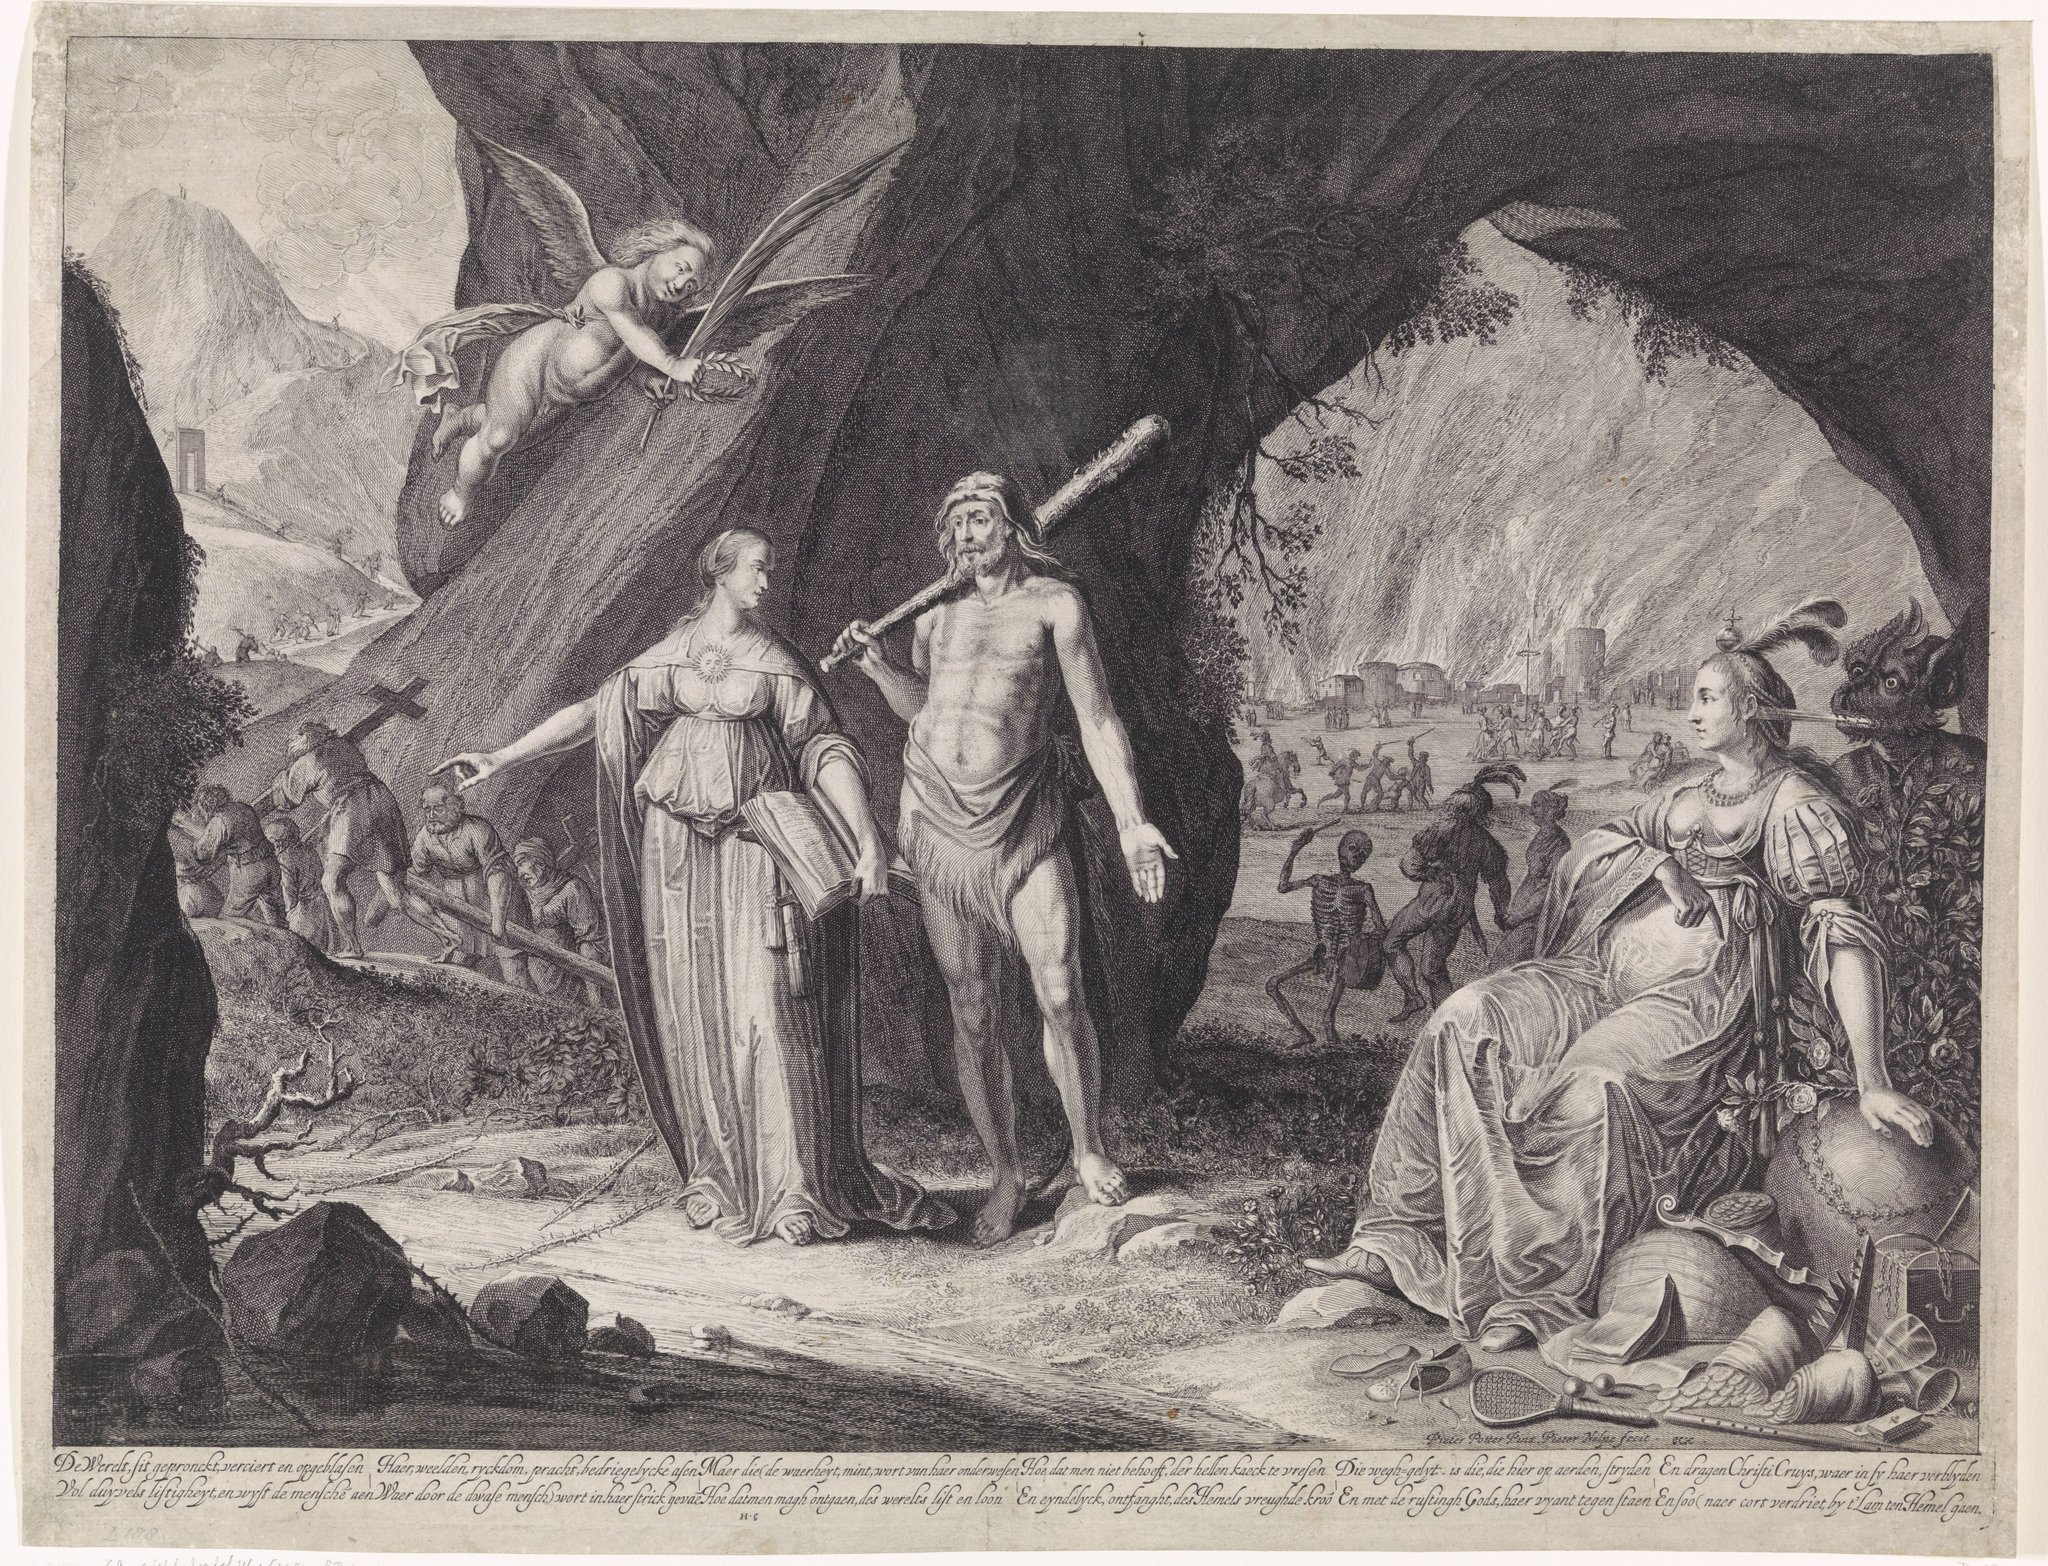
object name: print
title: Hercules op de tweesprong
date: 1623-1653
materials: paper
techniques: engraving, etching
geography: amsterdam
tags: apostles must take up their cross ~ the ideal apostle (matthew 10:38, 16:24; mark 8:34; luke 9:23, 14:27), devils in the form of (fabulous) animals, hercules at the cross-roads, 'herkules am scheidewege': the choice of hercules, truth; 'verità' (ripa), the way to destruction is broad and the gate is wide; the way to life is narrow and the gate is straight ~ doctrine of christ on love, etc. (matthew 7:13-14; luke 13:24), 'frau welt'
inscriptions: collector's mark: Lugt 240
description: Hercules staat met zijn knots op de schouder op de tweesprong. Hij moet kiezen tussen Waarheid en Wereld. Waarheid staat naast hem met een boek onder de arm en een zon op haar borst en wijst hem op de smalle weg. Wereld, met de rijksappel op haar hoofd, rust met haar hand op een globe, terwijl de duivel in haar oor blaast. Op de grond rond Wereld liggen allerlei rijkdommen. Achter Waarheid begint de smalle weg, waar de mensen hun kruis op zich nemen op weg naar de hemel. Achter Wereld begint de brede weg, die uitmondt in de hel. Onderaan in de marge staan twee toelichtende regels in het Nederlands.